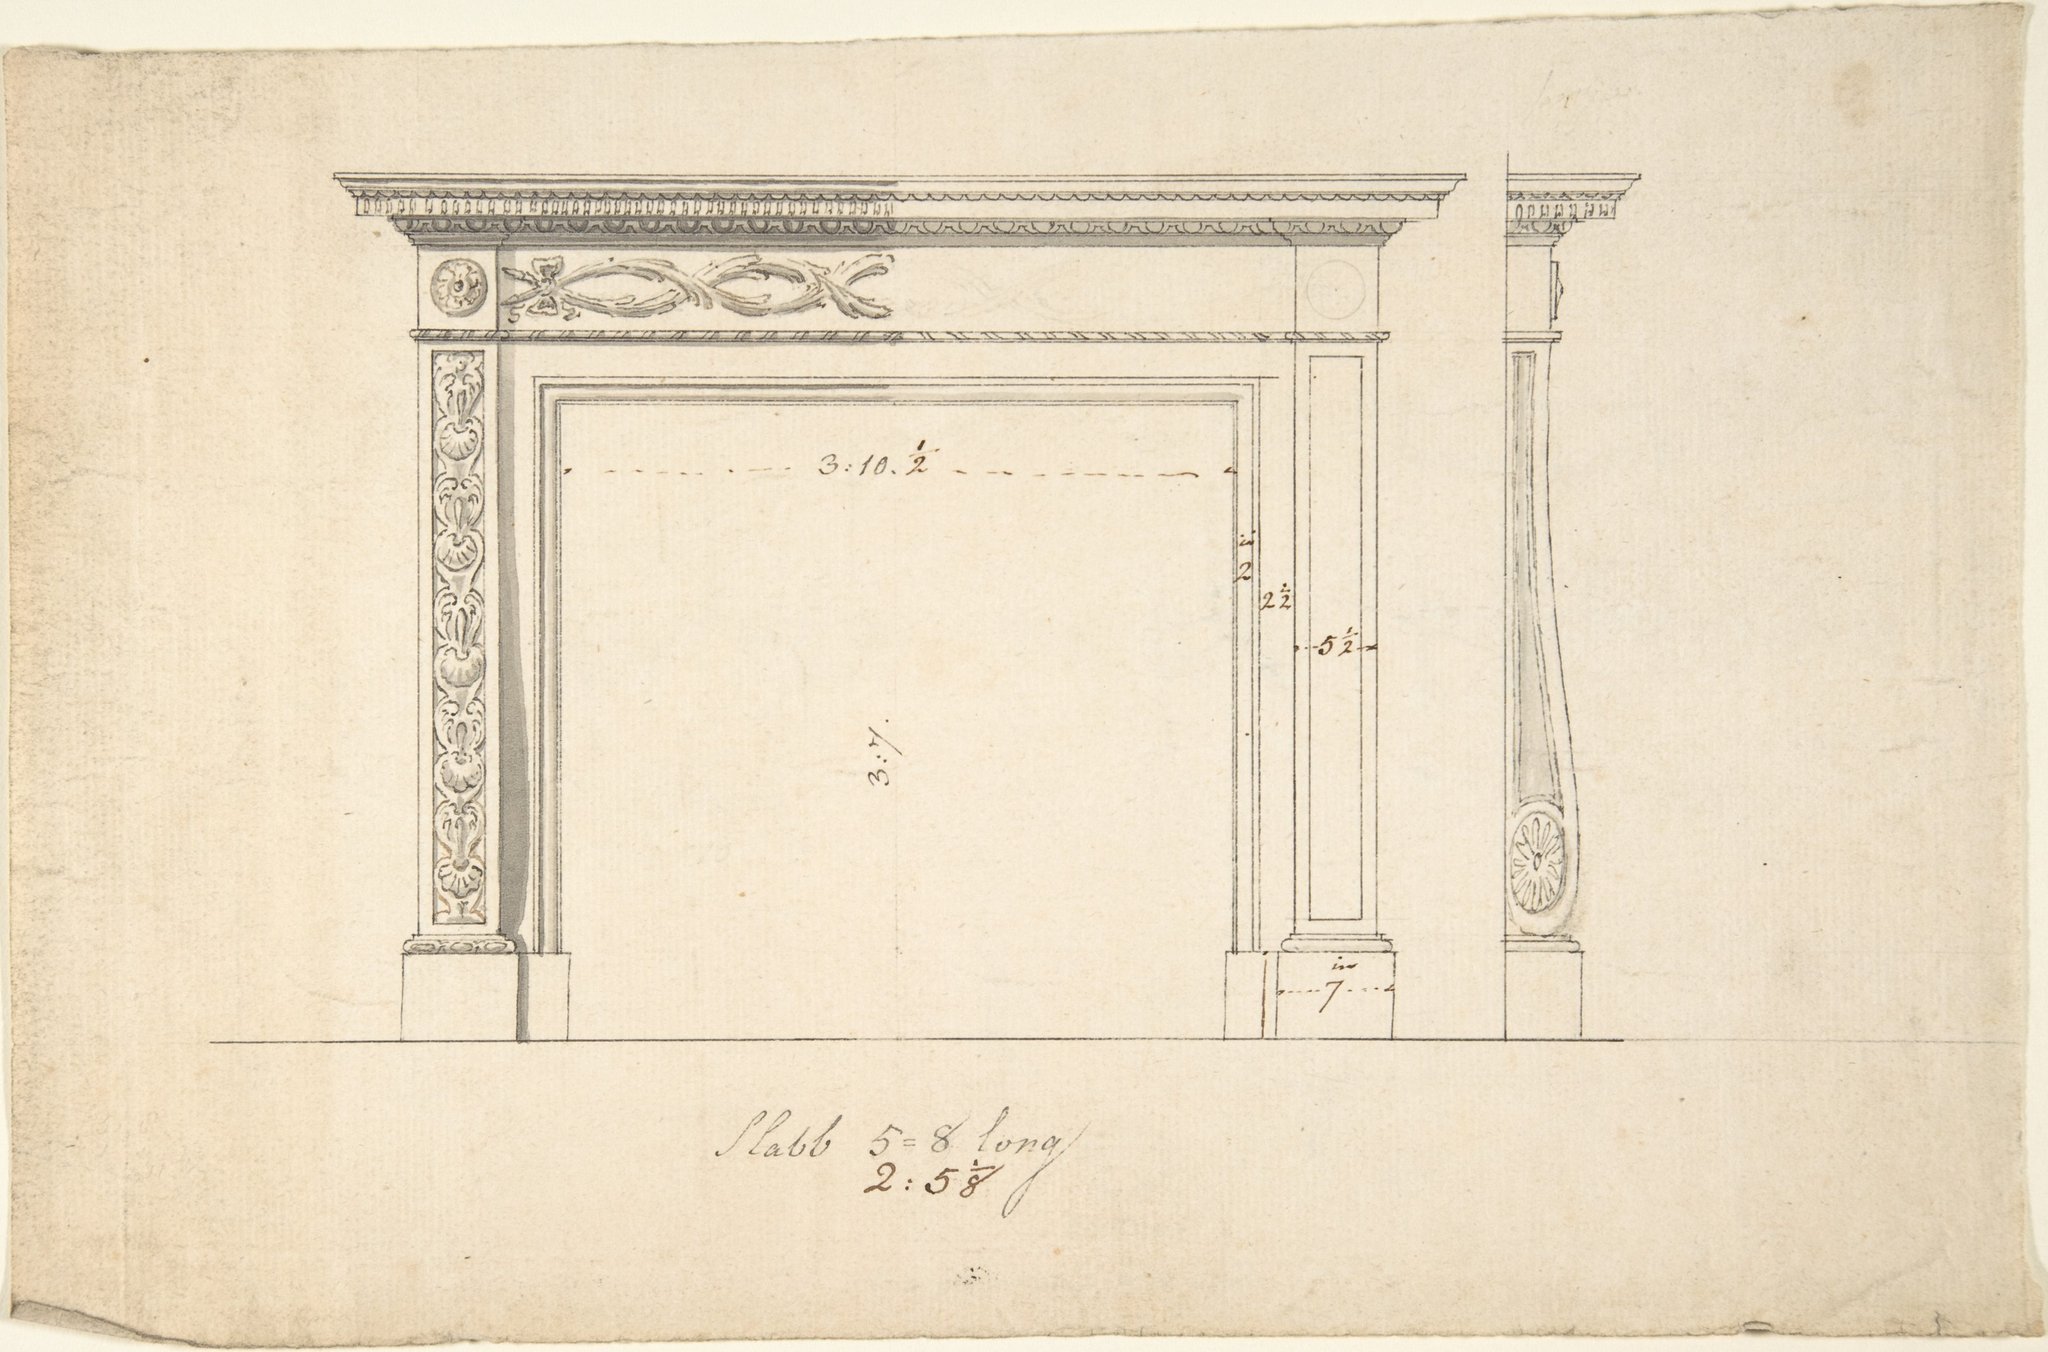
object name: drawing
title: Design for a Chimneypiece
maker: sir william chambers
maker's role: artist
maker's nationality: british, born sweden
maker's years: 1723-1796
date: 1740-1800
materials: ink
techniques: brush, pen, wash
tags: fireplaces